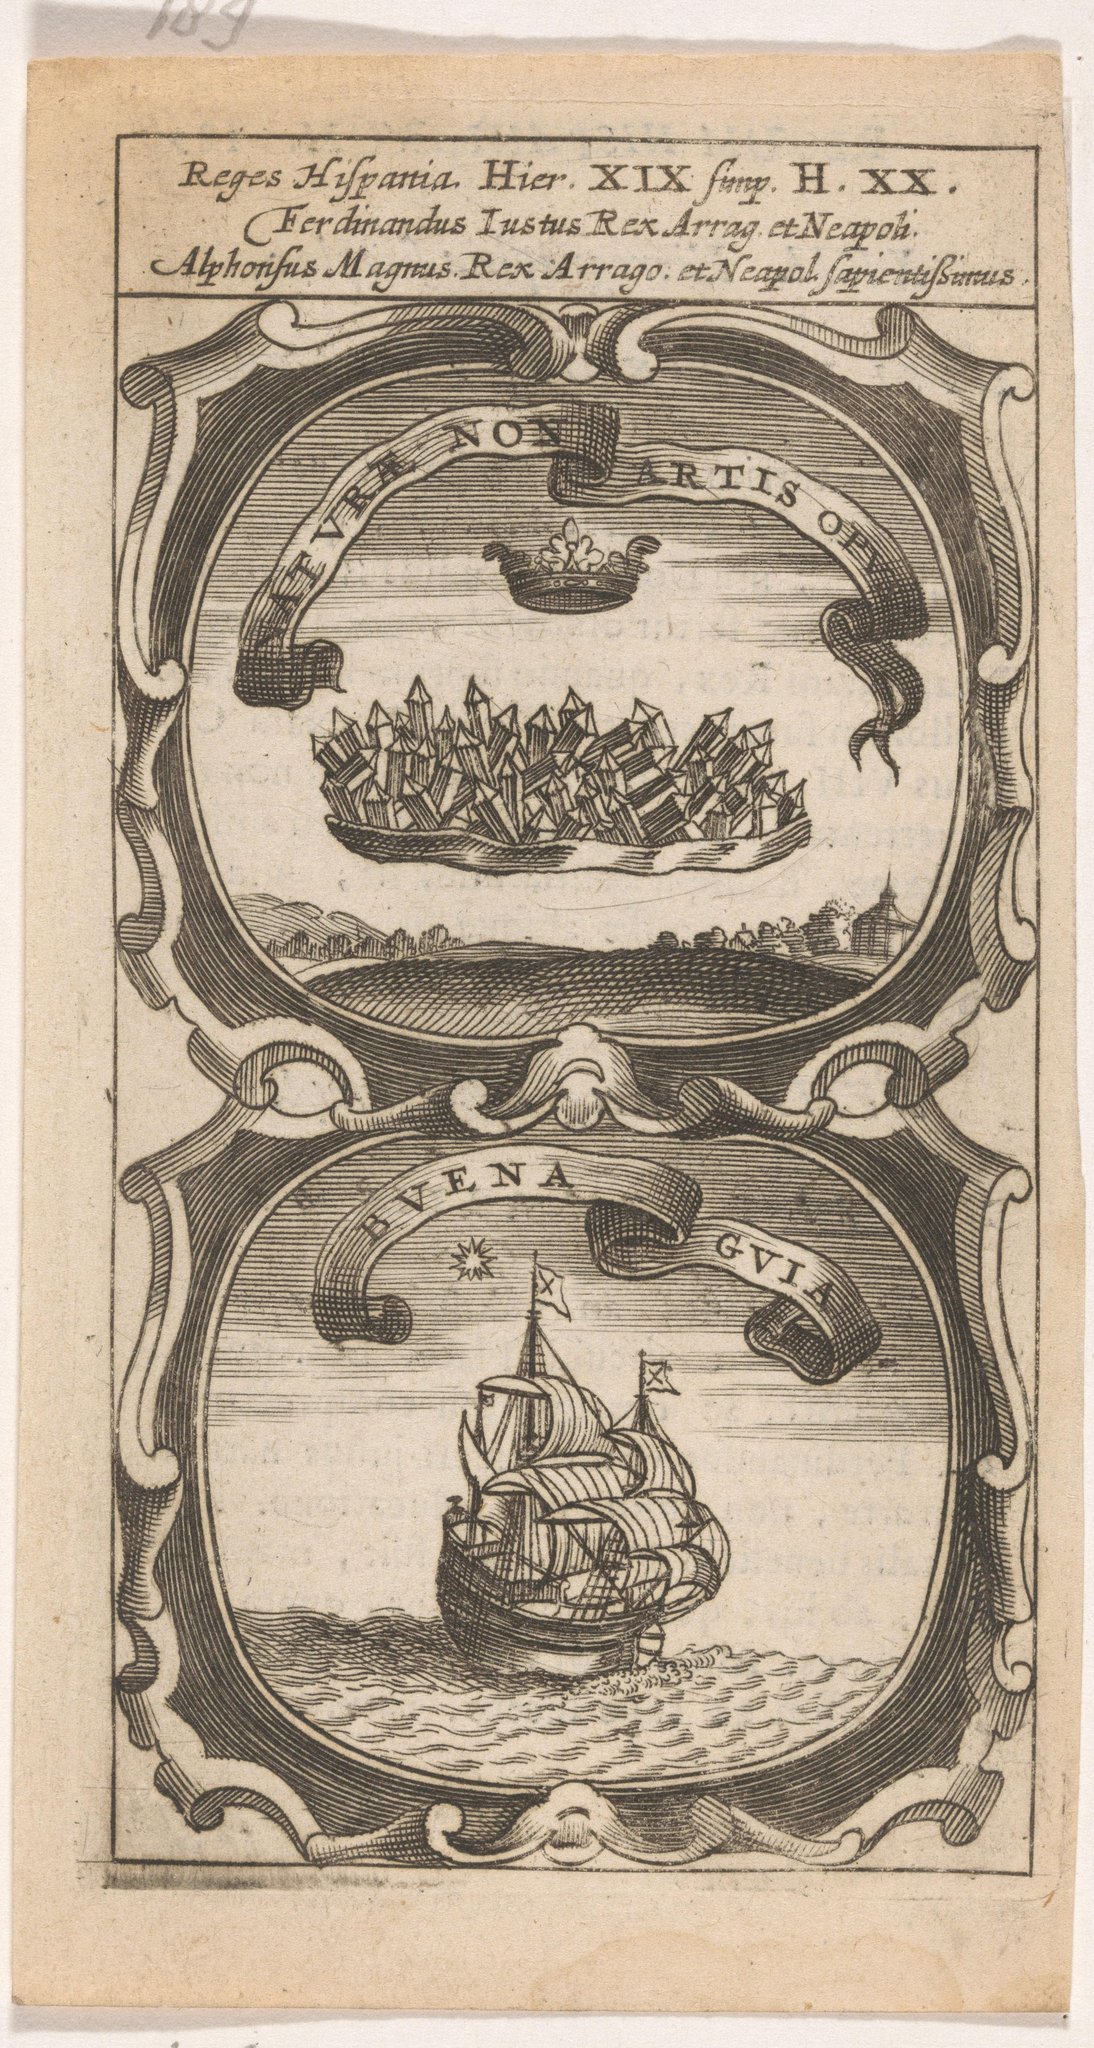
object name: print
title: Naturae Non Artis Opus / Buena Guia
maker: Anonymous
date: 1666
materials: paper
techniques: engraving, letterpress printing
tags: naples, crystals, ships (in general)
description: Een embleem met twee voorstellingen. Boven een landschap met daarboven zwevend een plateau met kristallen en een kroon. Onder een schip op zee. Daarbij de poolster. Het betreffen deviezen van koning Ferdinand II van Aragon en koning Alfons V van Aragon.